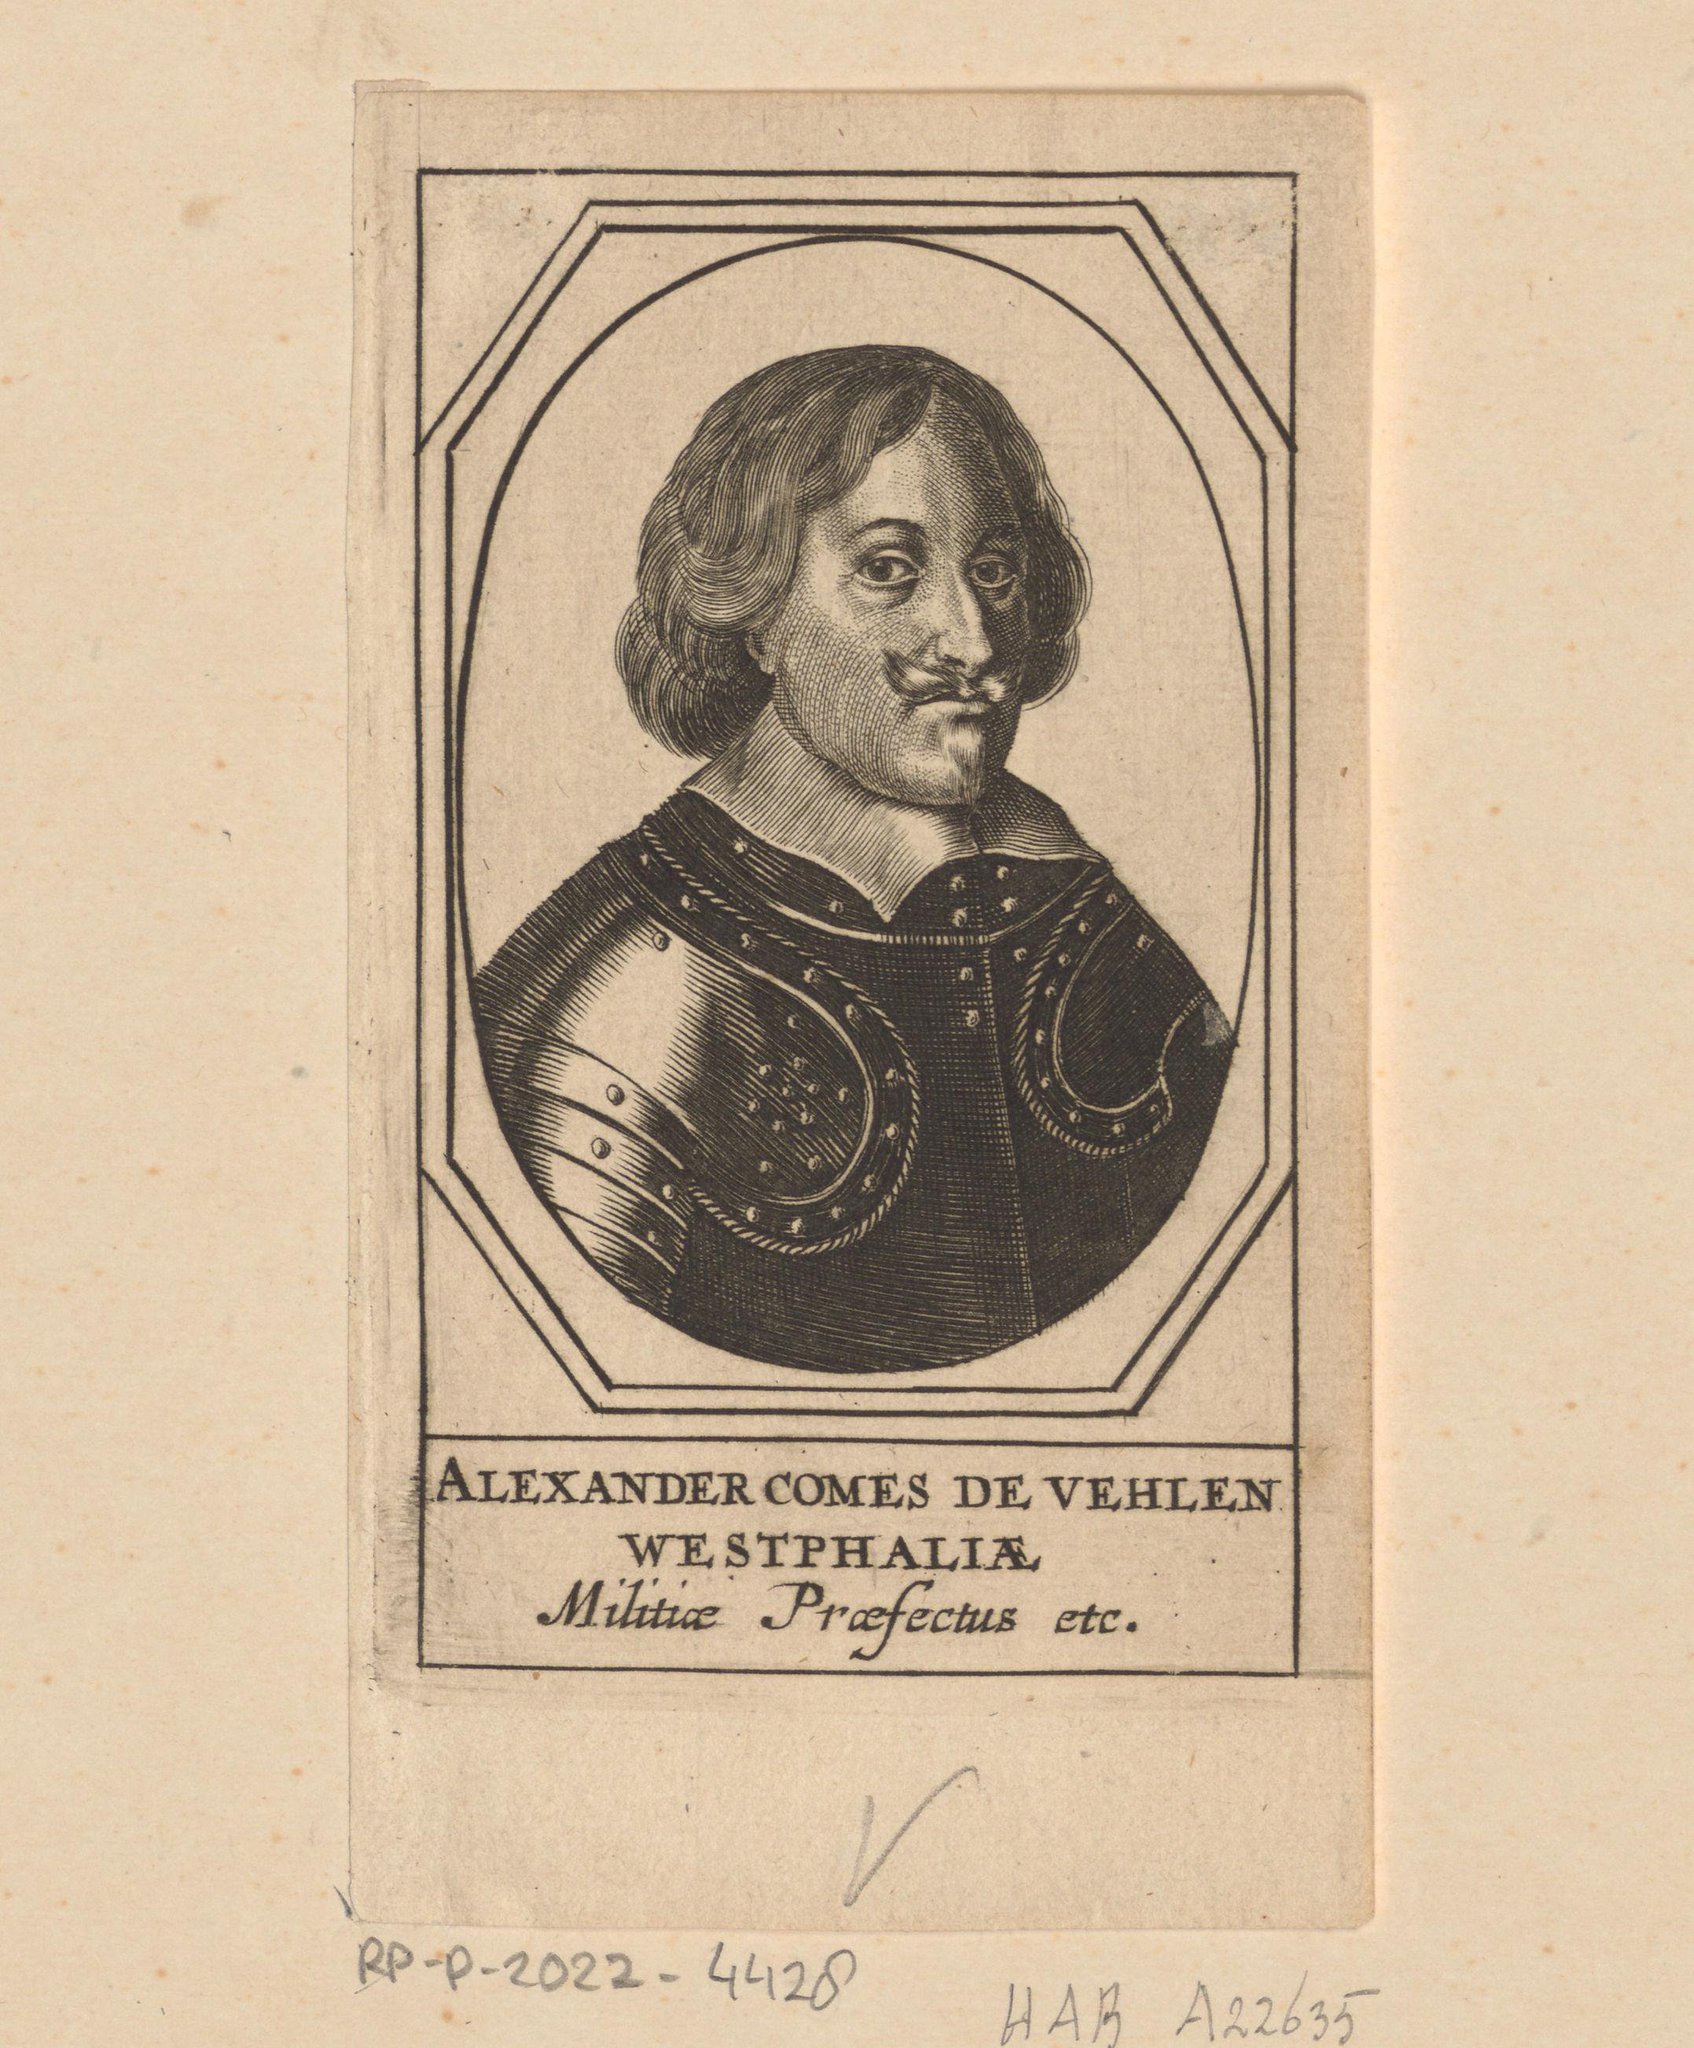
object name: book illustration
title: Portret van Alexander II van Vehlen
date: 1655-1659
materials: paper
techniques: engraving, etching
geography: northern netherlands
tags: commander-in-chief, general, marshal, historical persons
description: Prent uit: Brachelius, Johannes Adolphus. Historiarum nostri temporis editio ultima (…). Amsterdam: Jacob van Meurs en Johannes Janssonius, 1655. Prent ook gebruikt in de tweede editie van 1659.